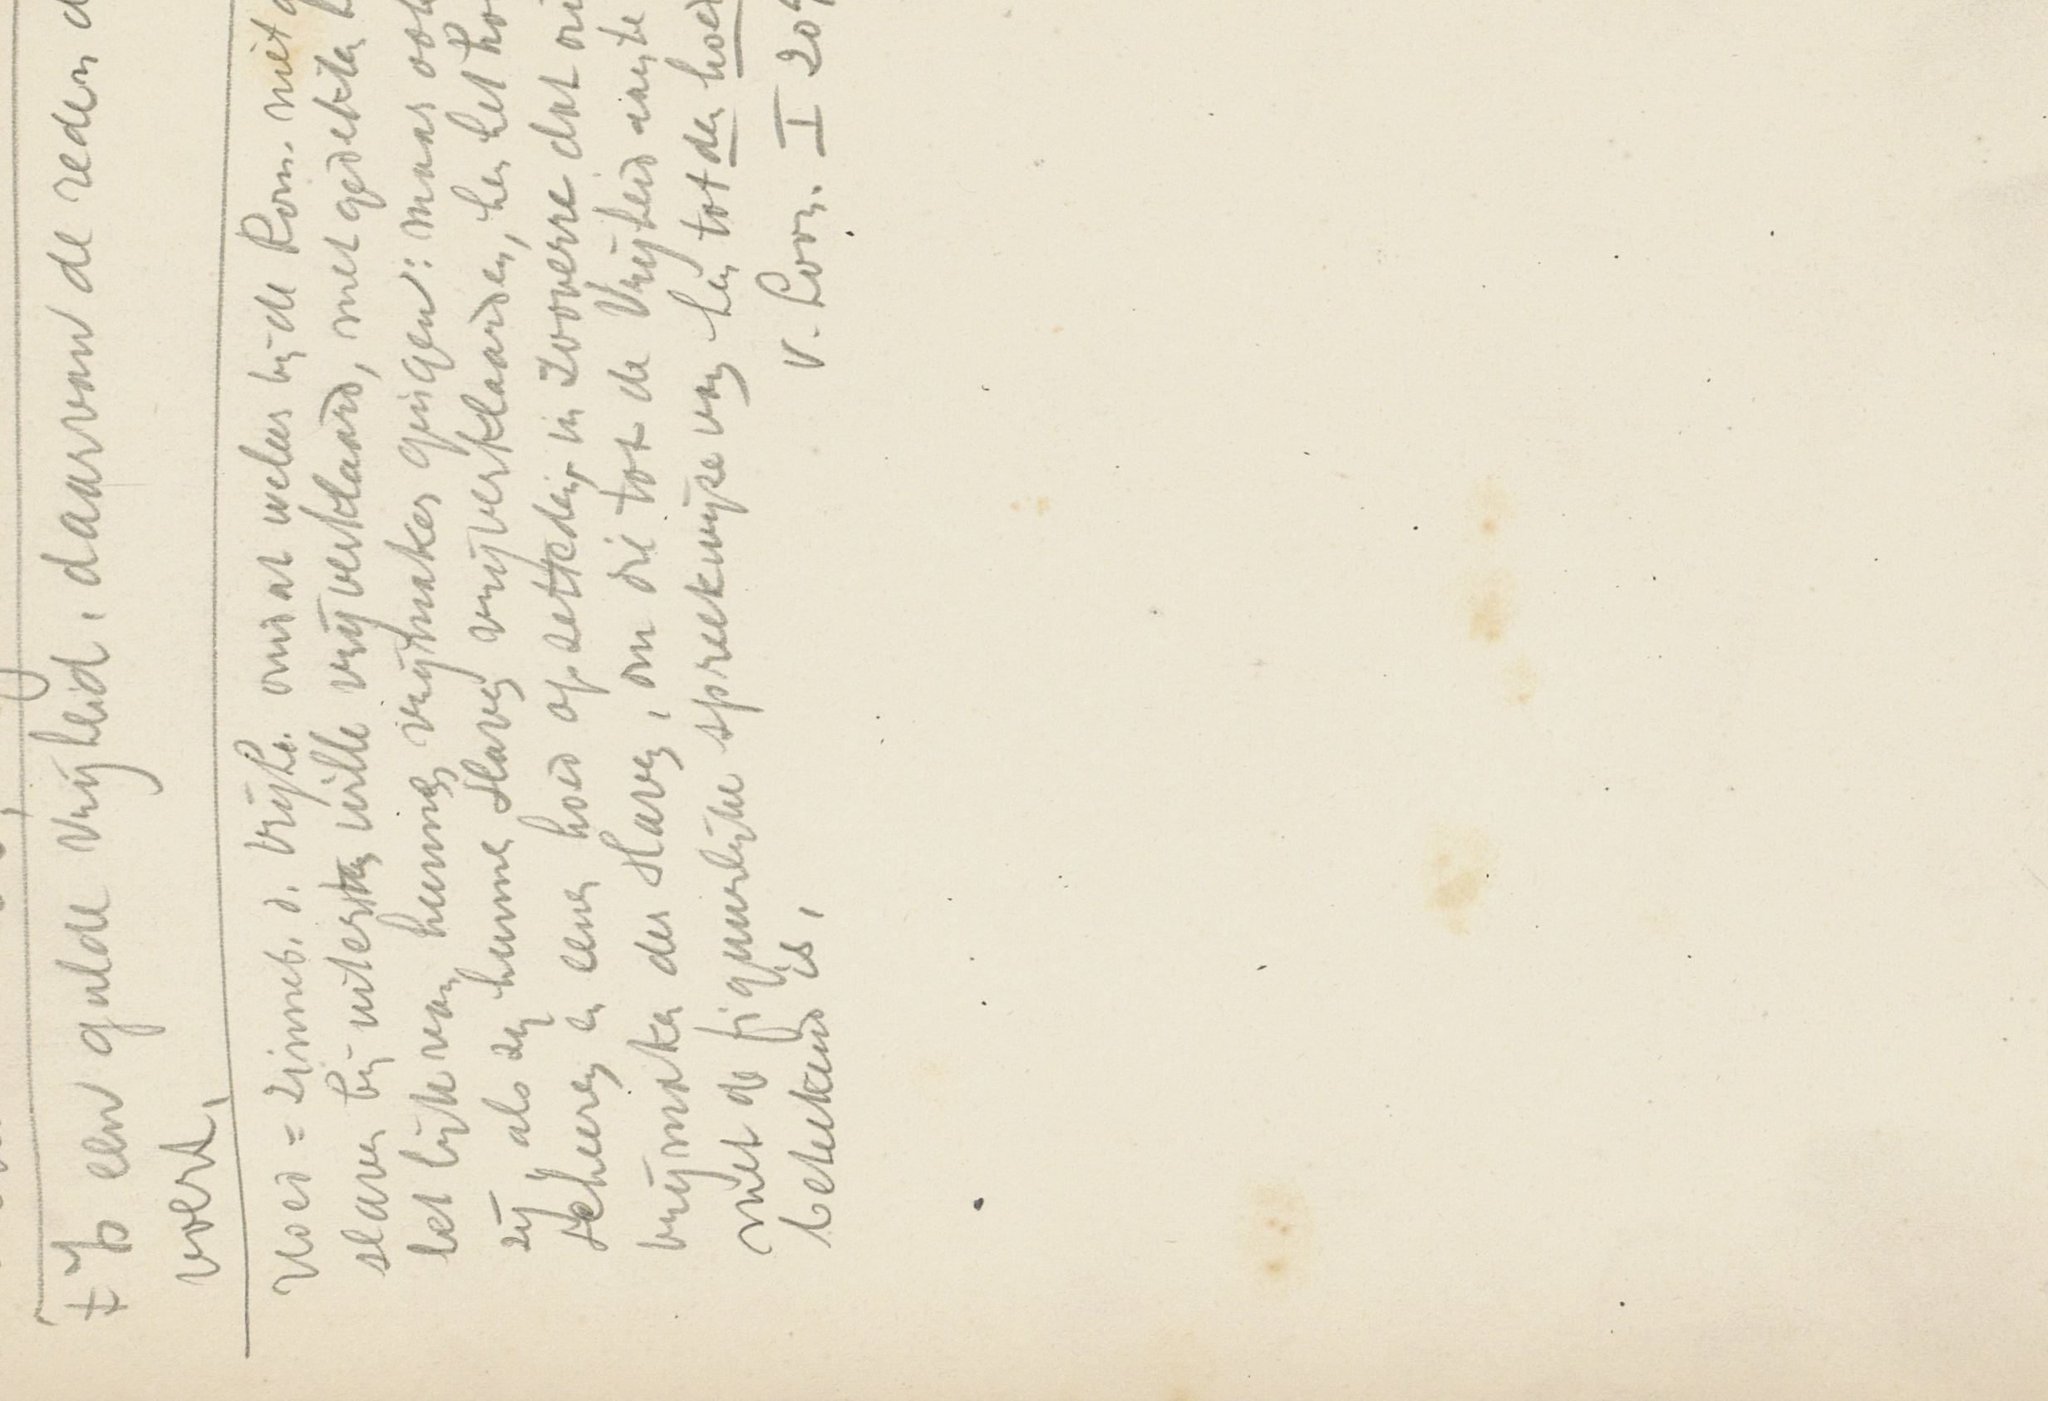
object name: sketchbook leaf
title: Notities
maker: antoon derkinderen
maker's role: draughtsman, painter, print maker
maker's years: 1859-1925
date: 1900-1903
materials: paper, pencil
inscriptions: annotation: ‘Libertas aurea, enjus moderatus habenas ratio/ t is een gulde vrijheid, daarvan de reden der [...]engel/ voert/ [...] v. Loon. I 204’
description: Blad 13 verso uit een schetsboek met 45 bladen.